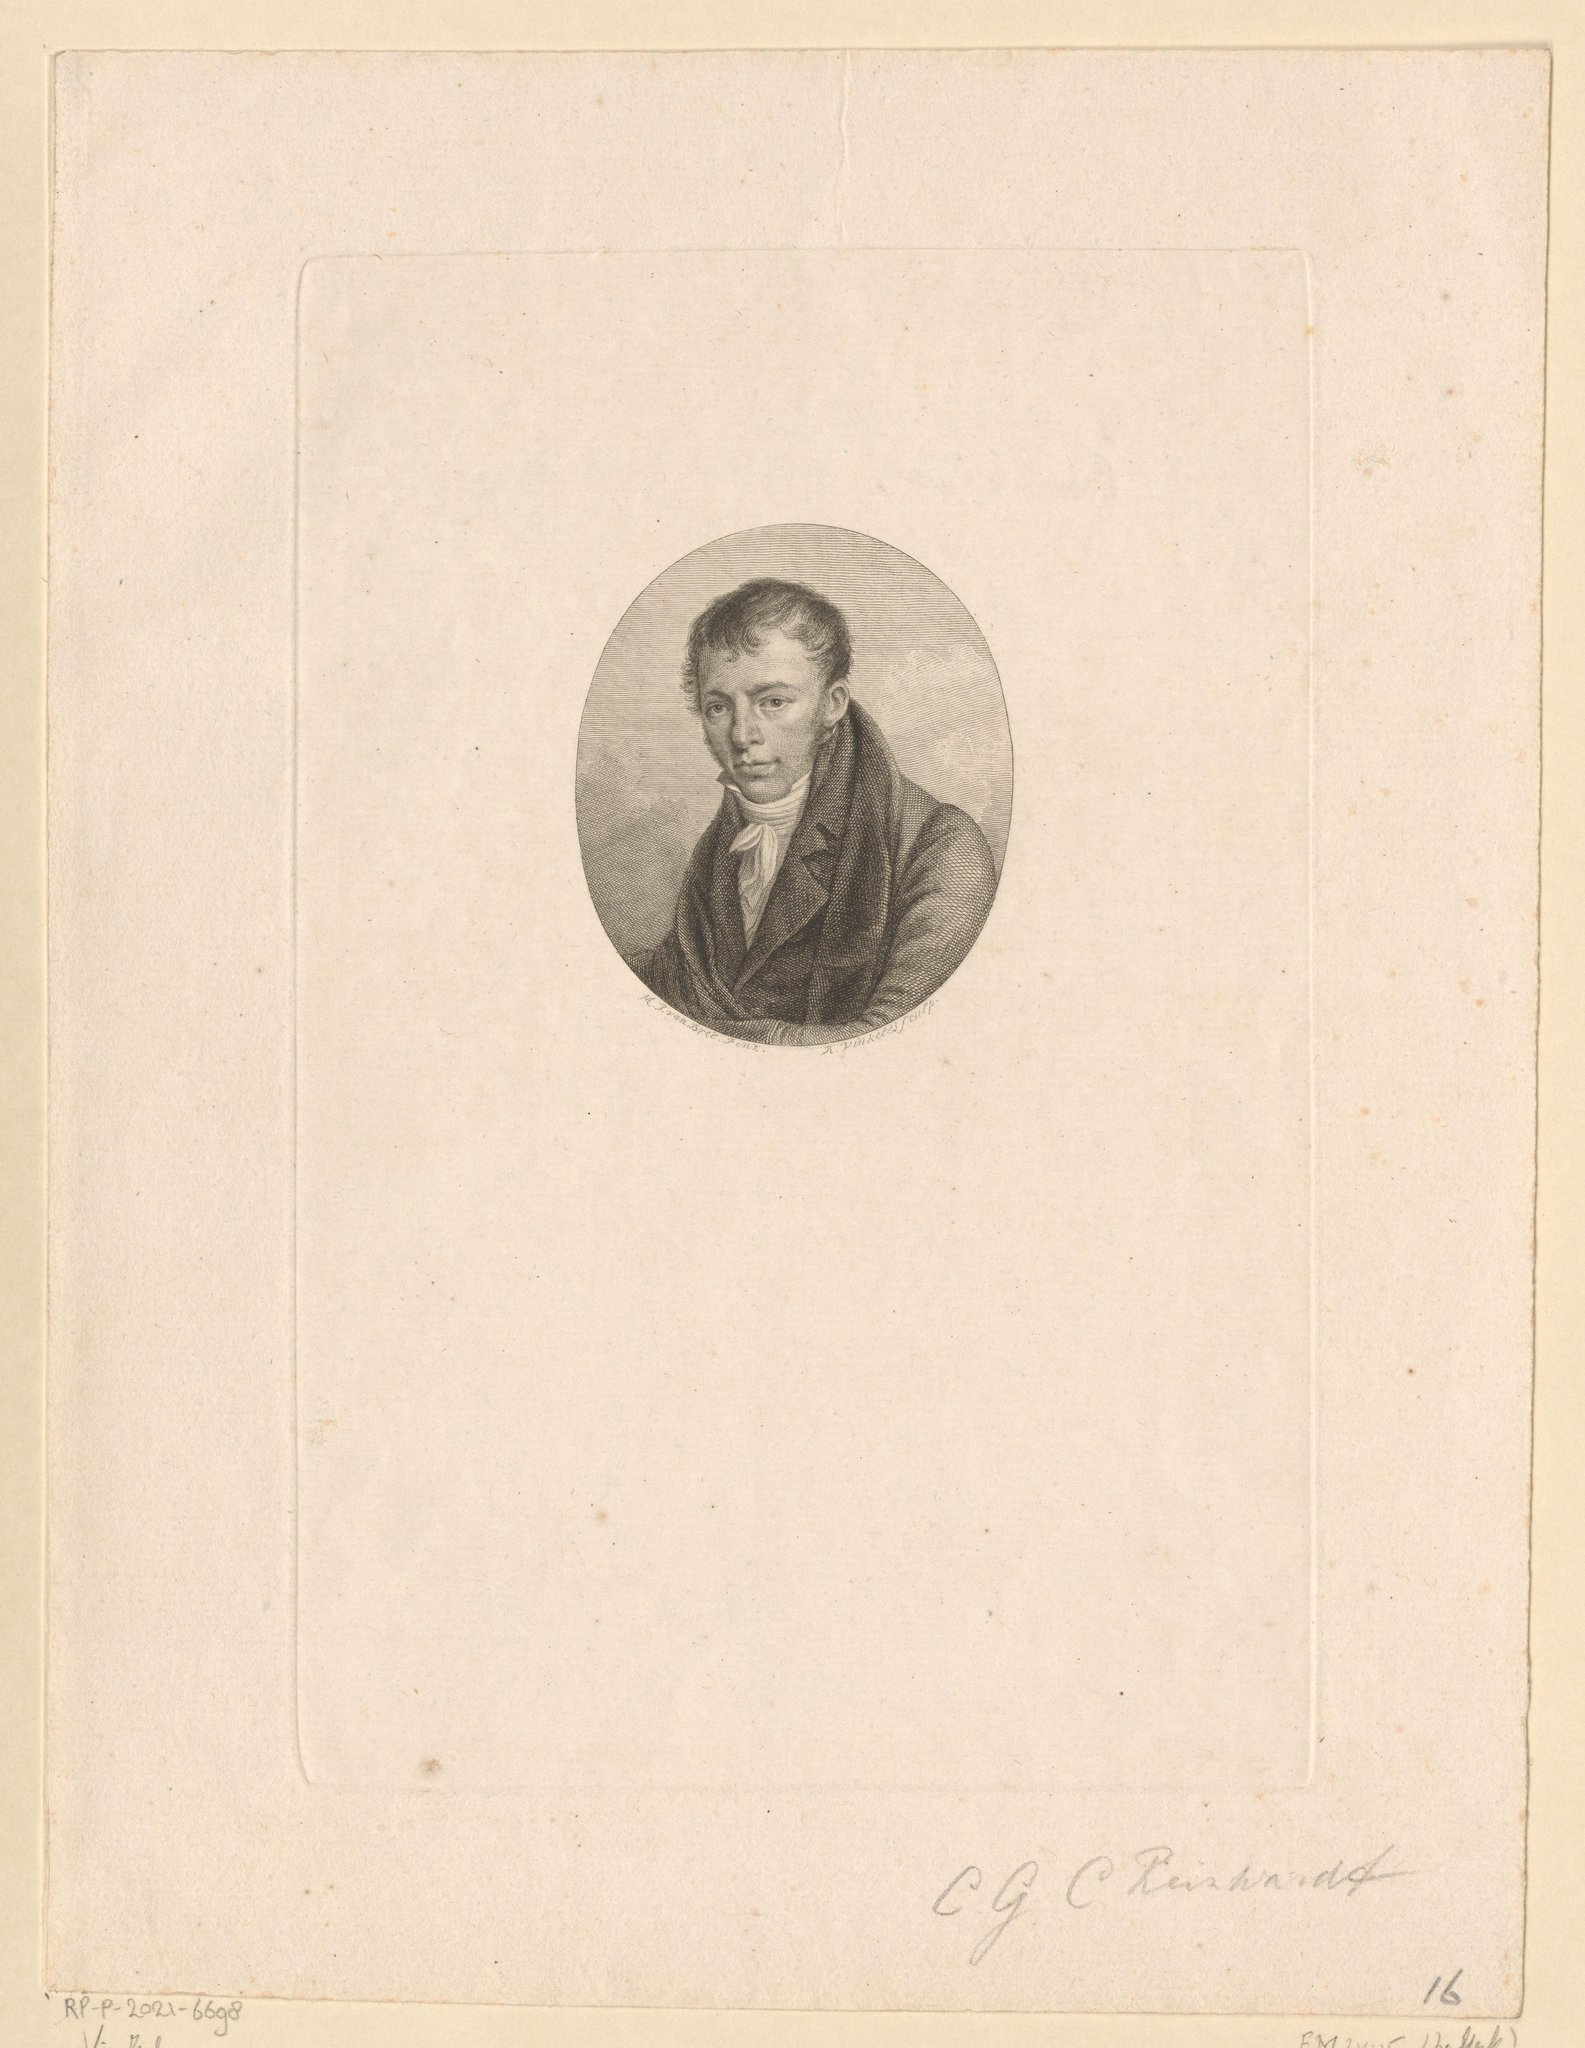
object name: print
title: Portret van Caspar Georg Carl Reinwardt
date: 1800-1816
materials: paper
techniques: engraving, etching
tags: caspar georg carl reinwardt, historical persons